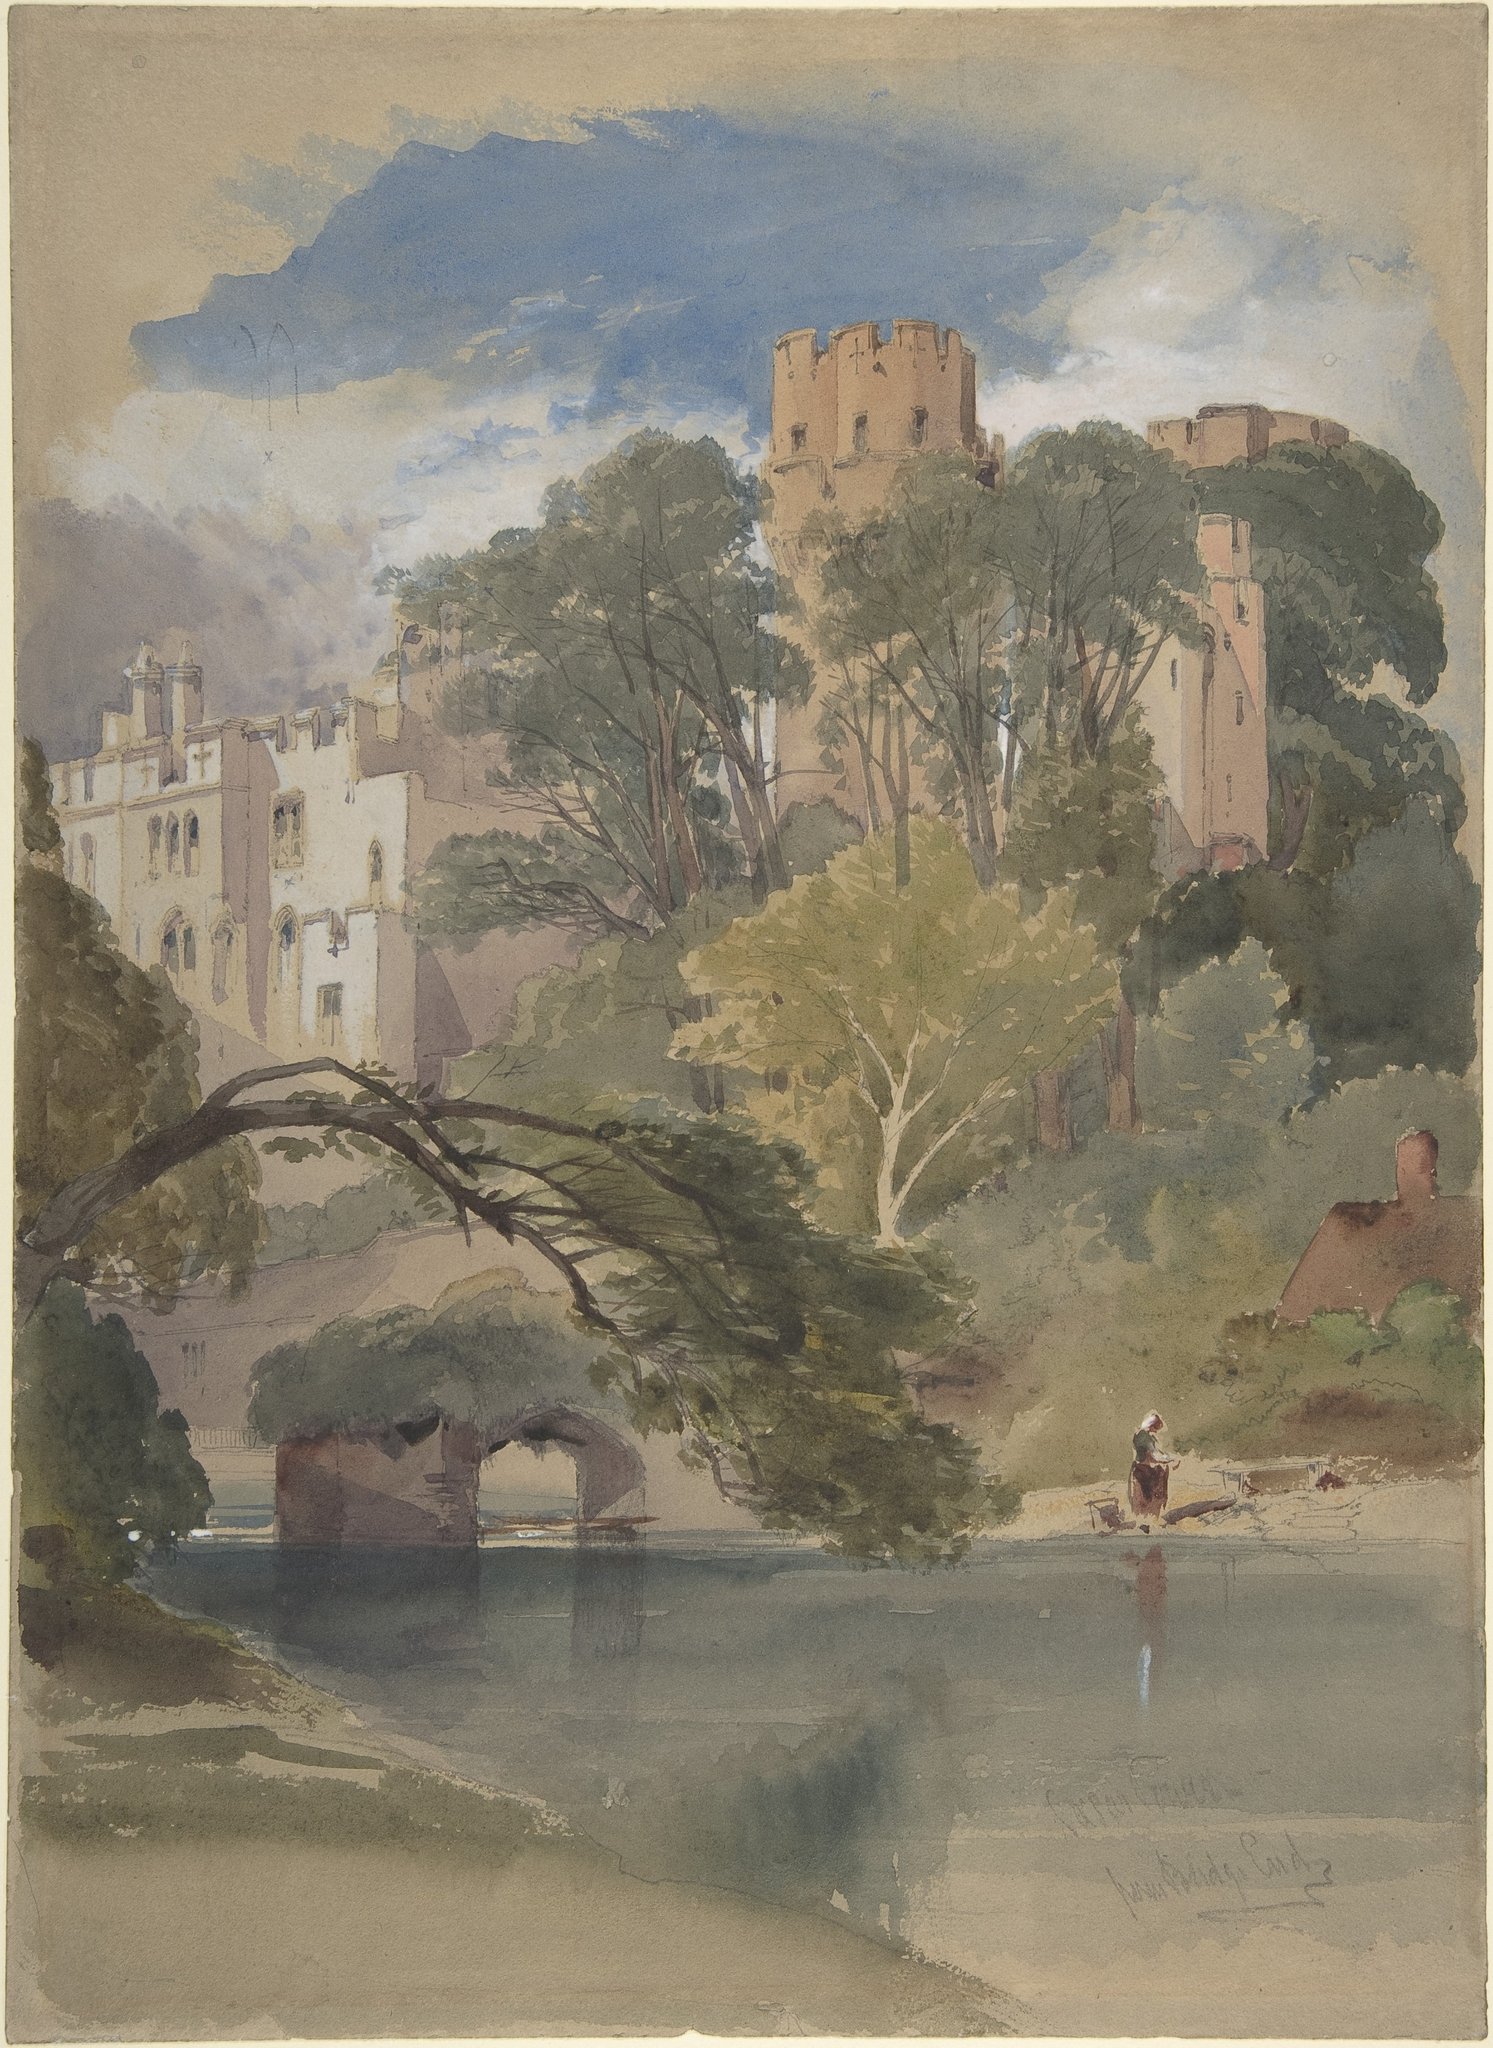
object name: drawing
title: Caesar's Tower, Warwick Castle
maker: william callow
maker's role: artist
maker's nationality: british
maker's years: 1812-1908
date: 1850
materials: gouache, graphite, watercolor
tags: castles,landscapes,trees